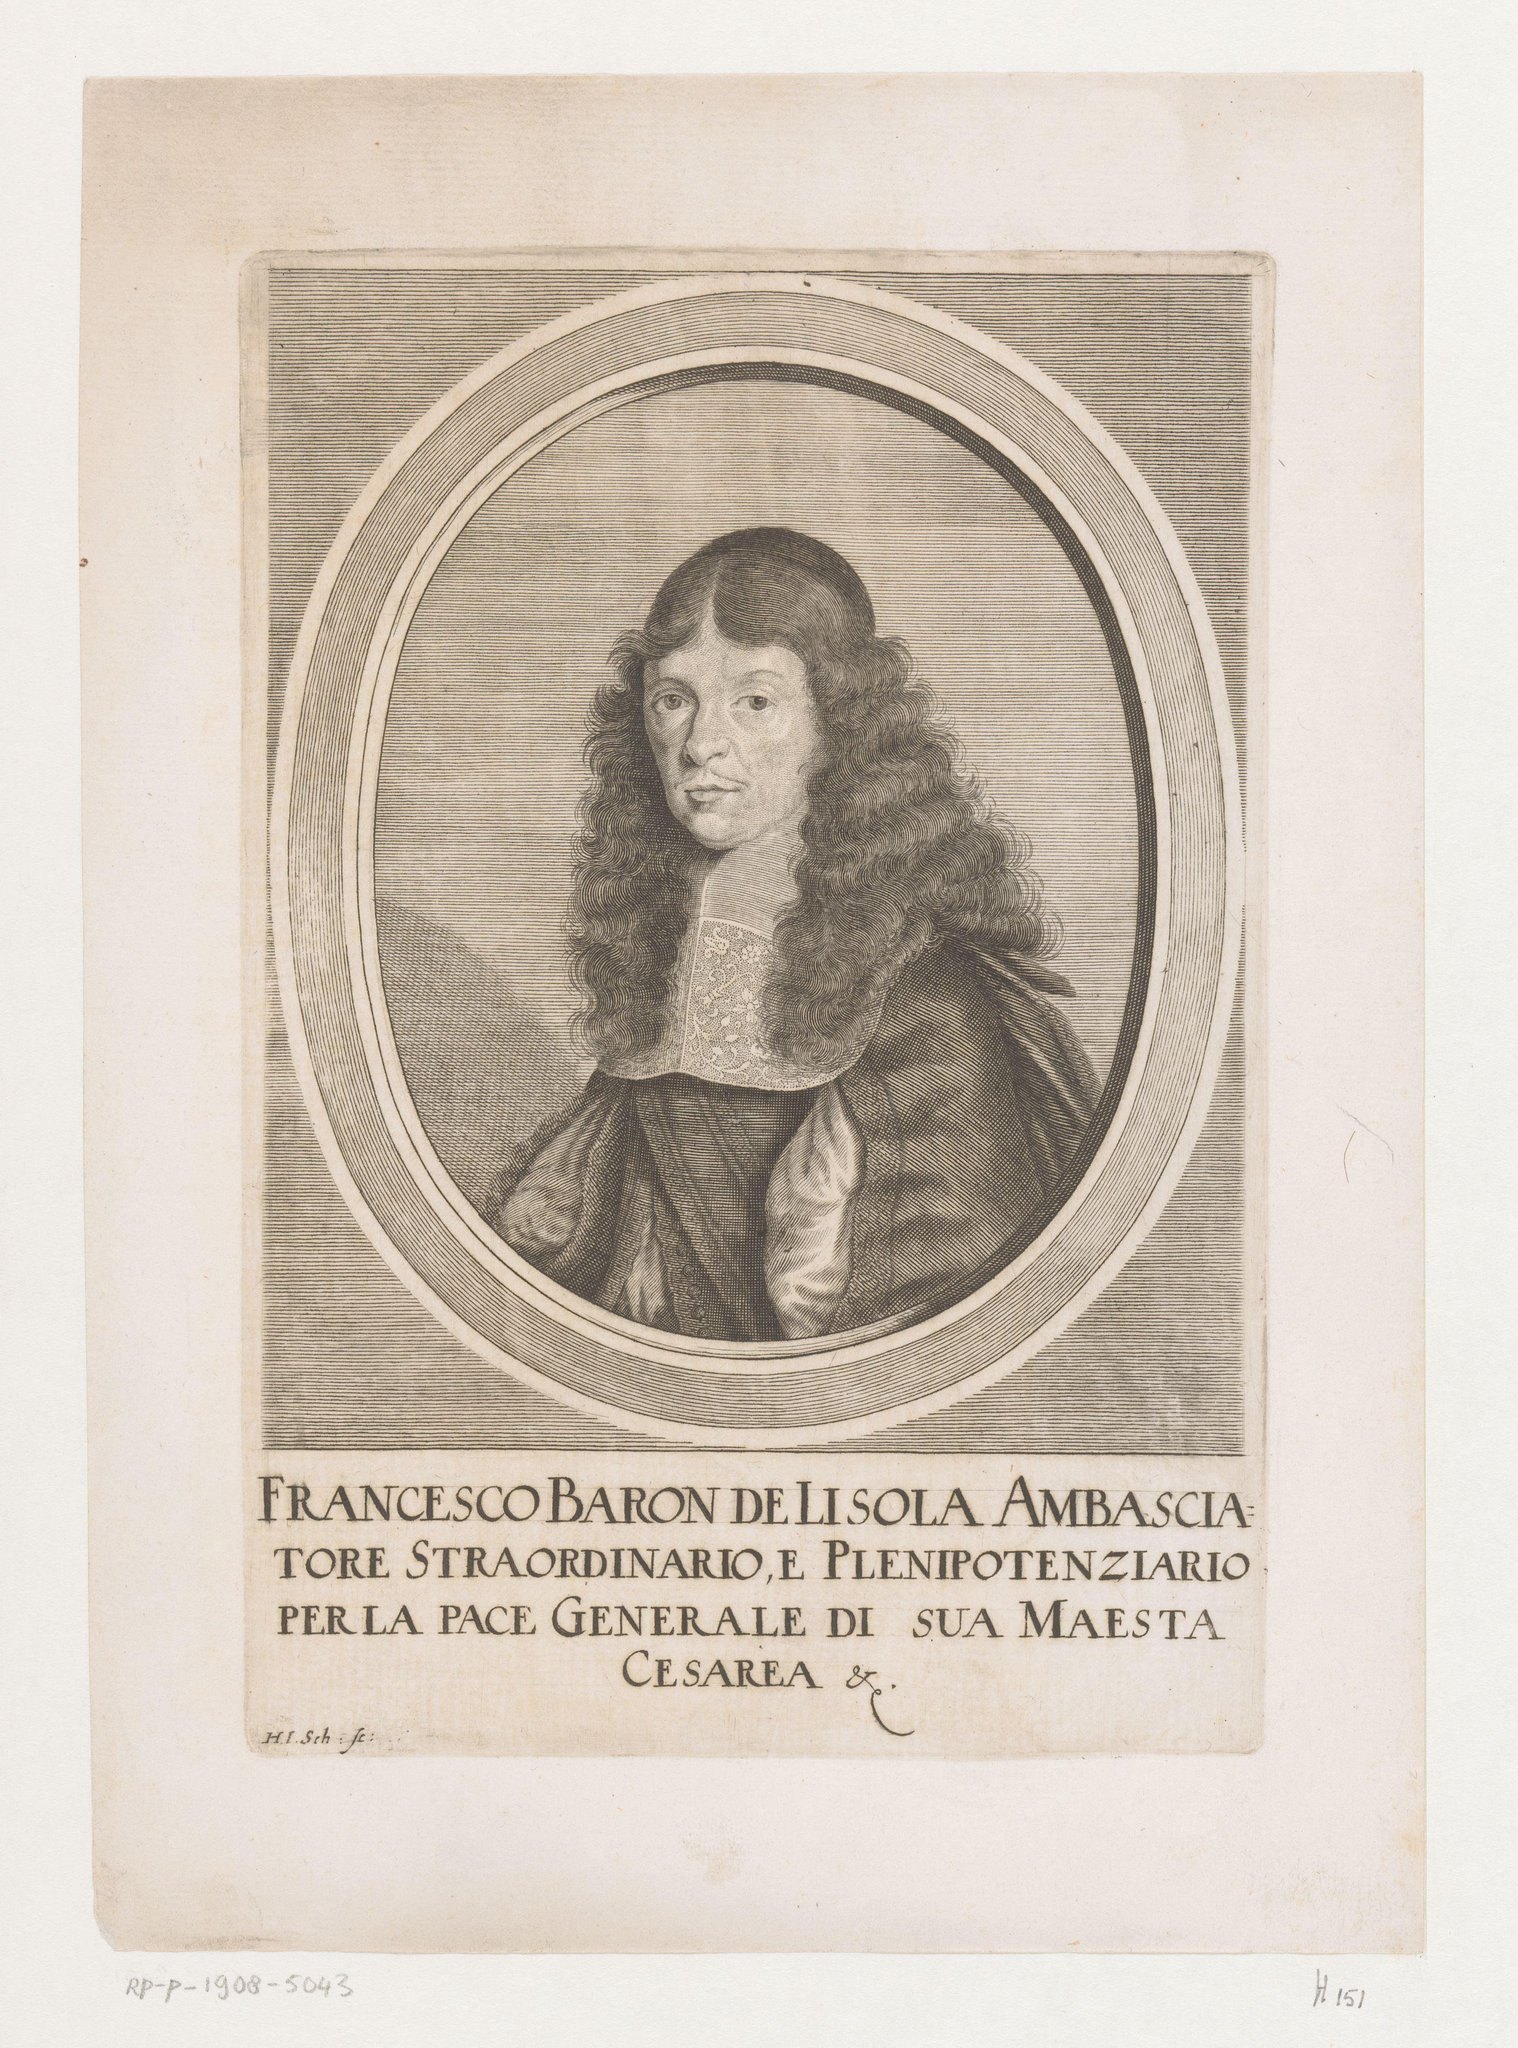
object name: print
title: Portret van François Paul de Lisola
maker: johann jacob schollenberger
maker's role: print maker, publisher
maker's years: 1646-1689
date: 1670-1674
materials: paper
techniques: engraving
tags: historical persons, diplomacy, diplomat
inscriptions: collector's mark: Lugt 2228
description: Deze prent is ook gebruikt in: Priorato, Galeazzo Gualdo. Historia di Leopoldo Cesare, Continente le cose piu memorabili successe in Europa dal 1656 fino al 1670. Descritta dal Co. Galeazzo Gvaldo Priorato. Wenen: G. B. Hacque, 1670-1674.